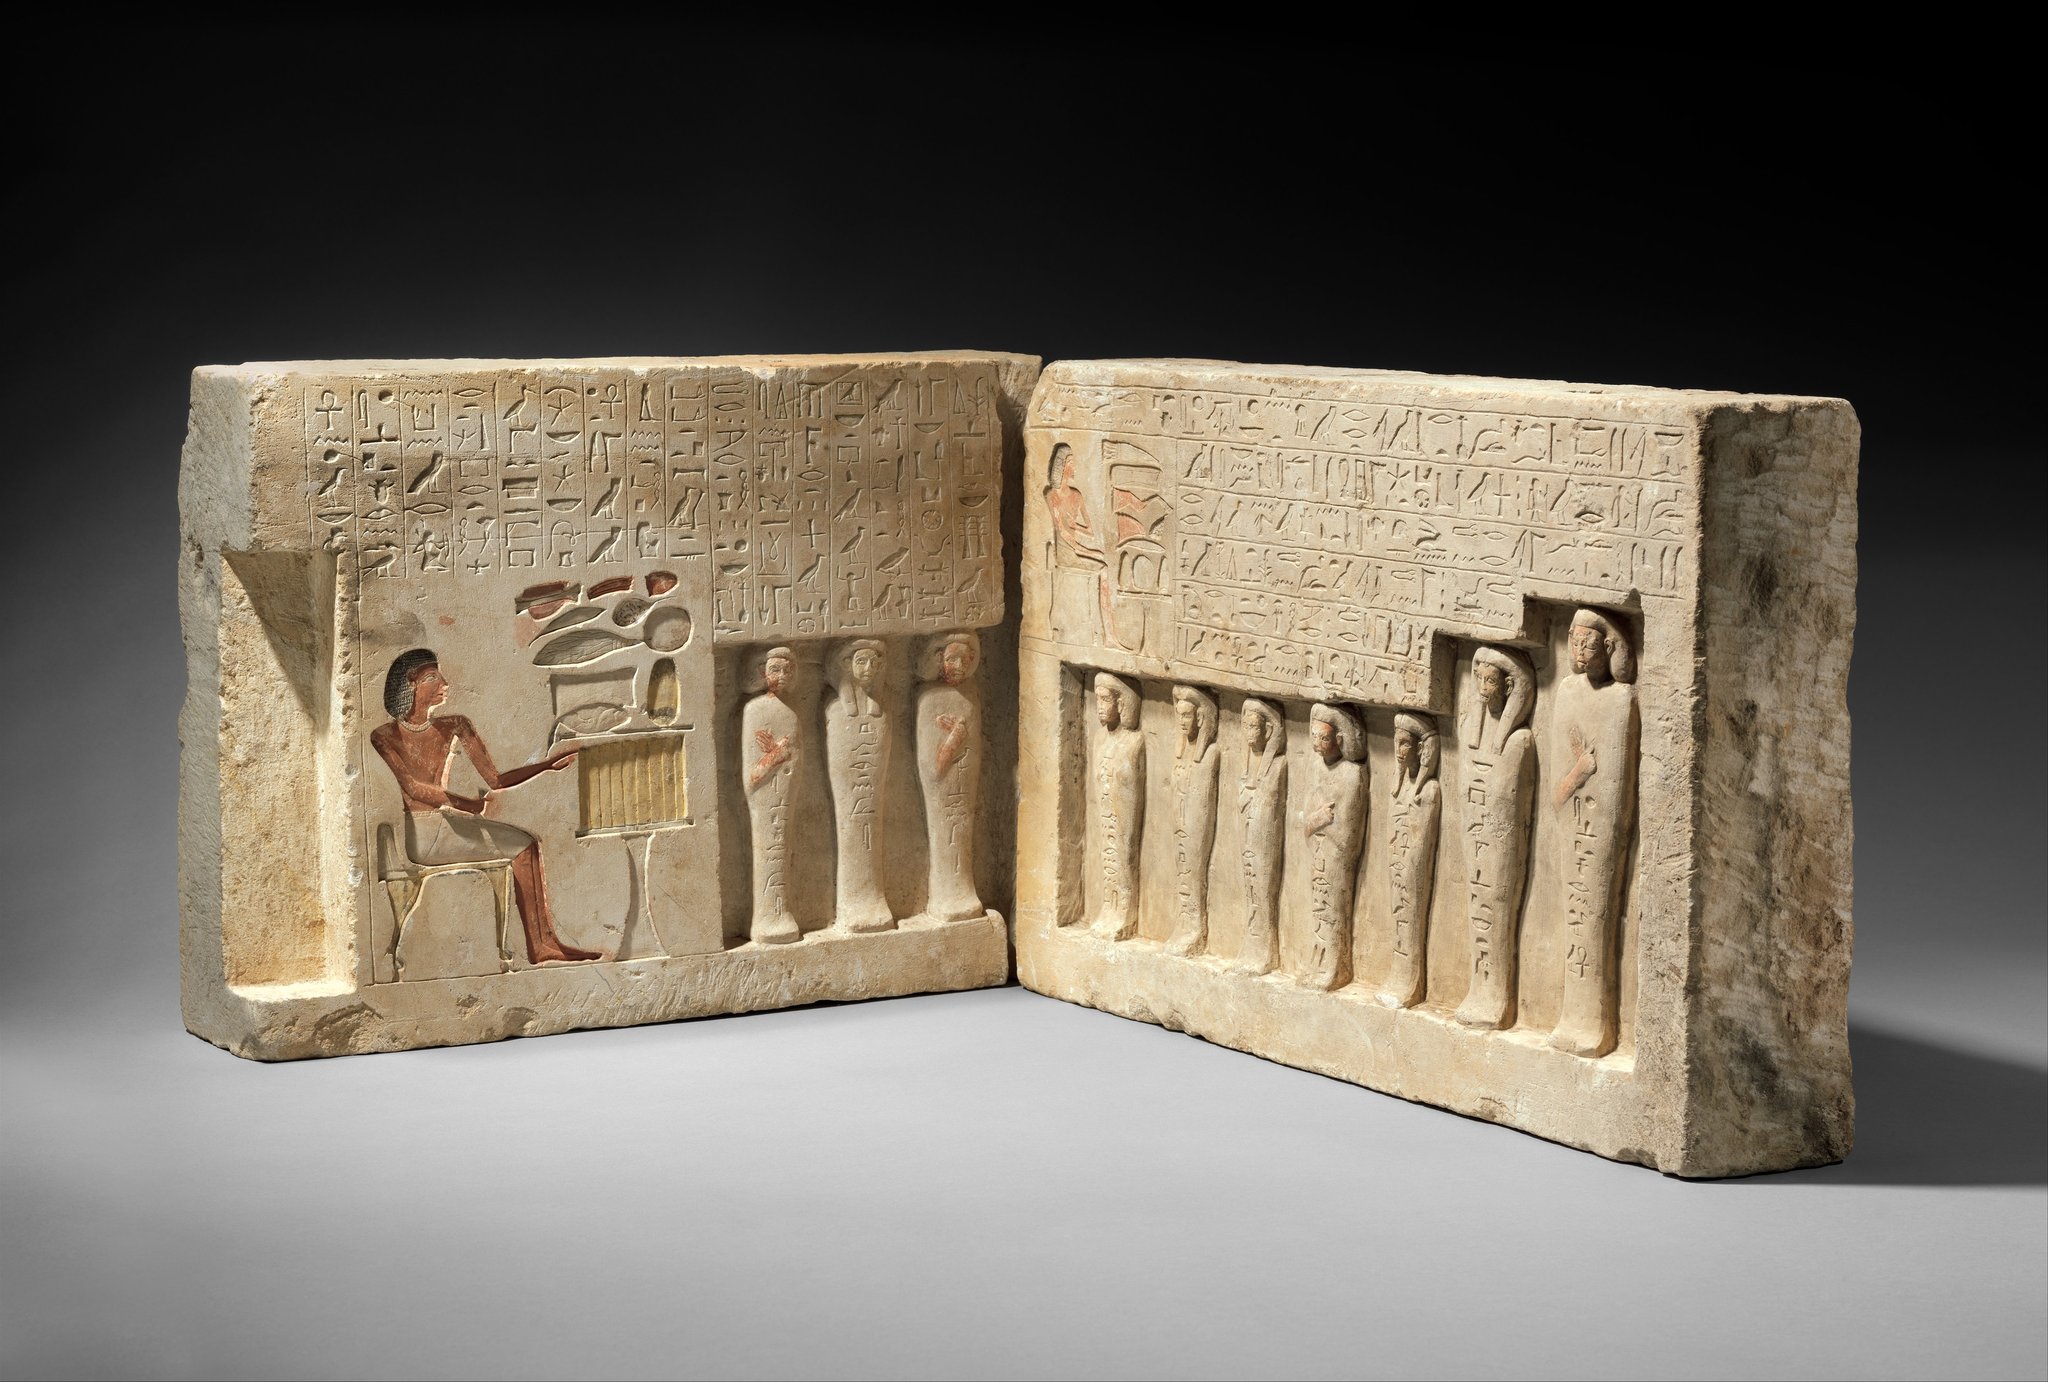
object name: relief, funerary chapel, sehetepibre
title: Reliefs from the Chapel of the Overseer of the Troops Sehetepibre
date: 1802-1640 BCE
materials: limestone, paint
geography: egypt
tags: men,women,hieroglyphs